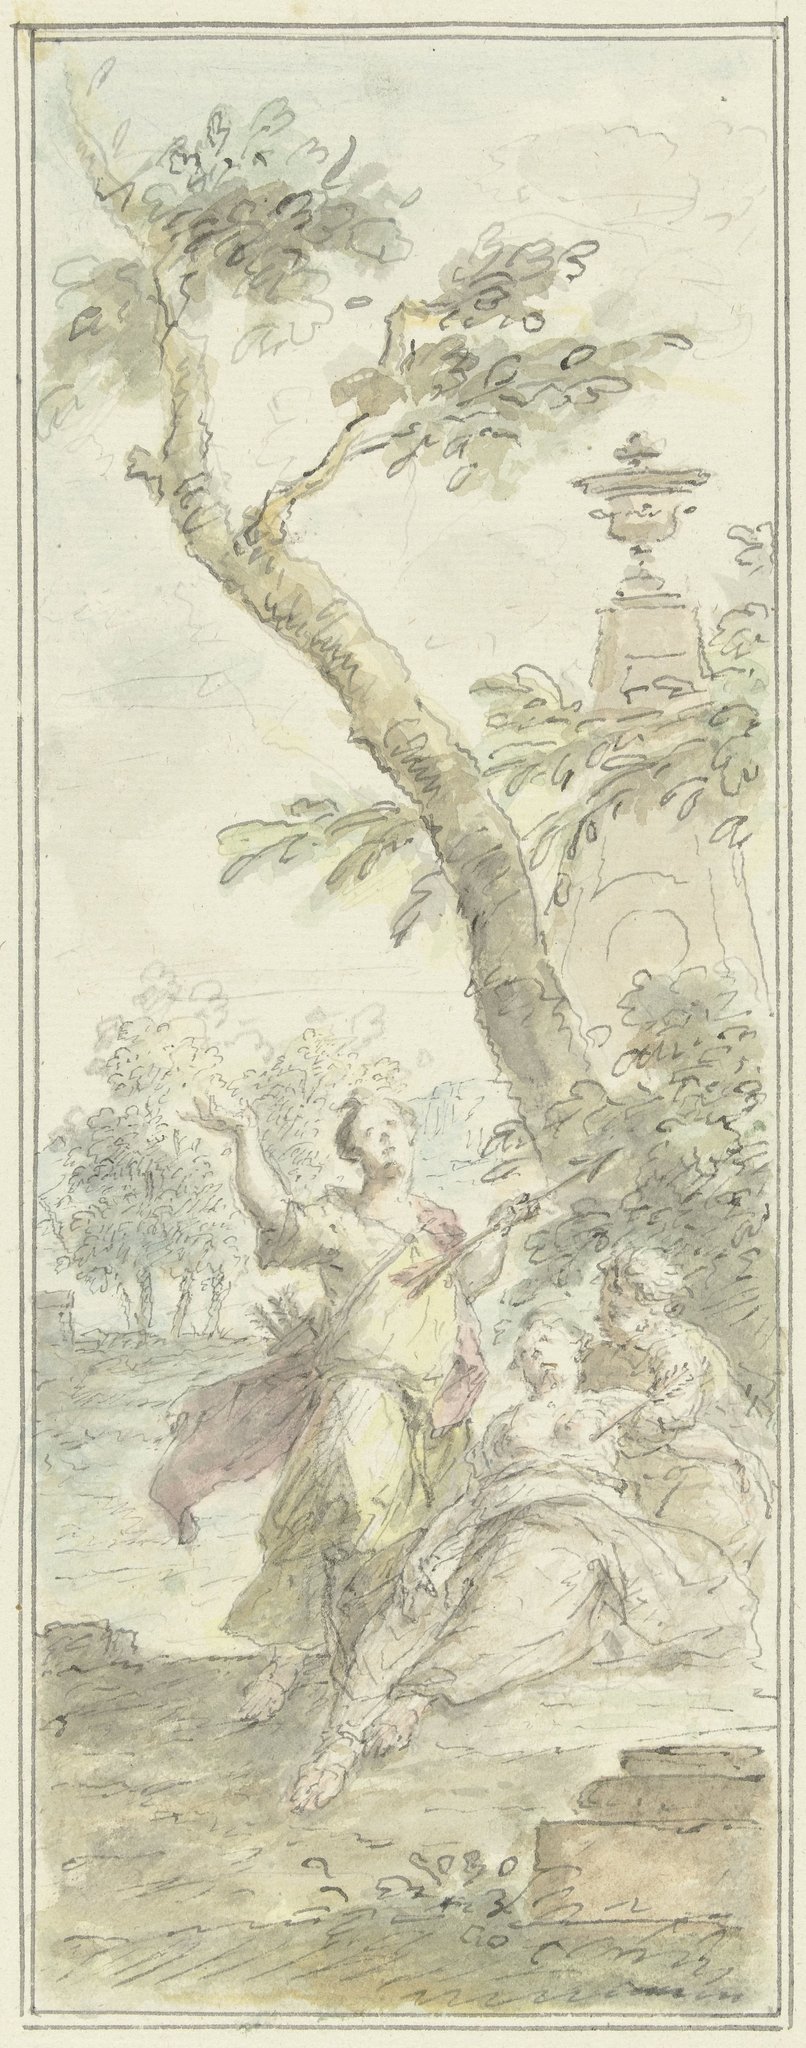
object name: design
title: Ontwerp voor een zaalstuk: Dorinda getroffen door Silvio's pijl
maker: dionys van nijmegen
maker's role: draughtsman, painter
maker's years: 1705-1798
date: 1715-1798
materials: ink, paper, pencil, watercolor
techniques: brush, pen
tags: violent death by arrow(s) - ee - death not certain; wounded person (+ finding of dead or dying person), (scenes from) specific works of literature: guarini, pastor fido